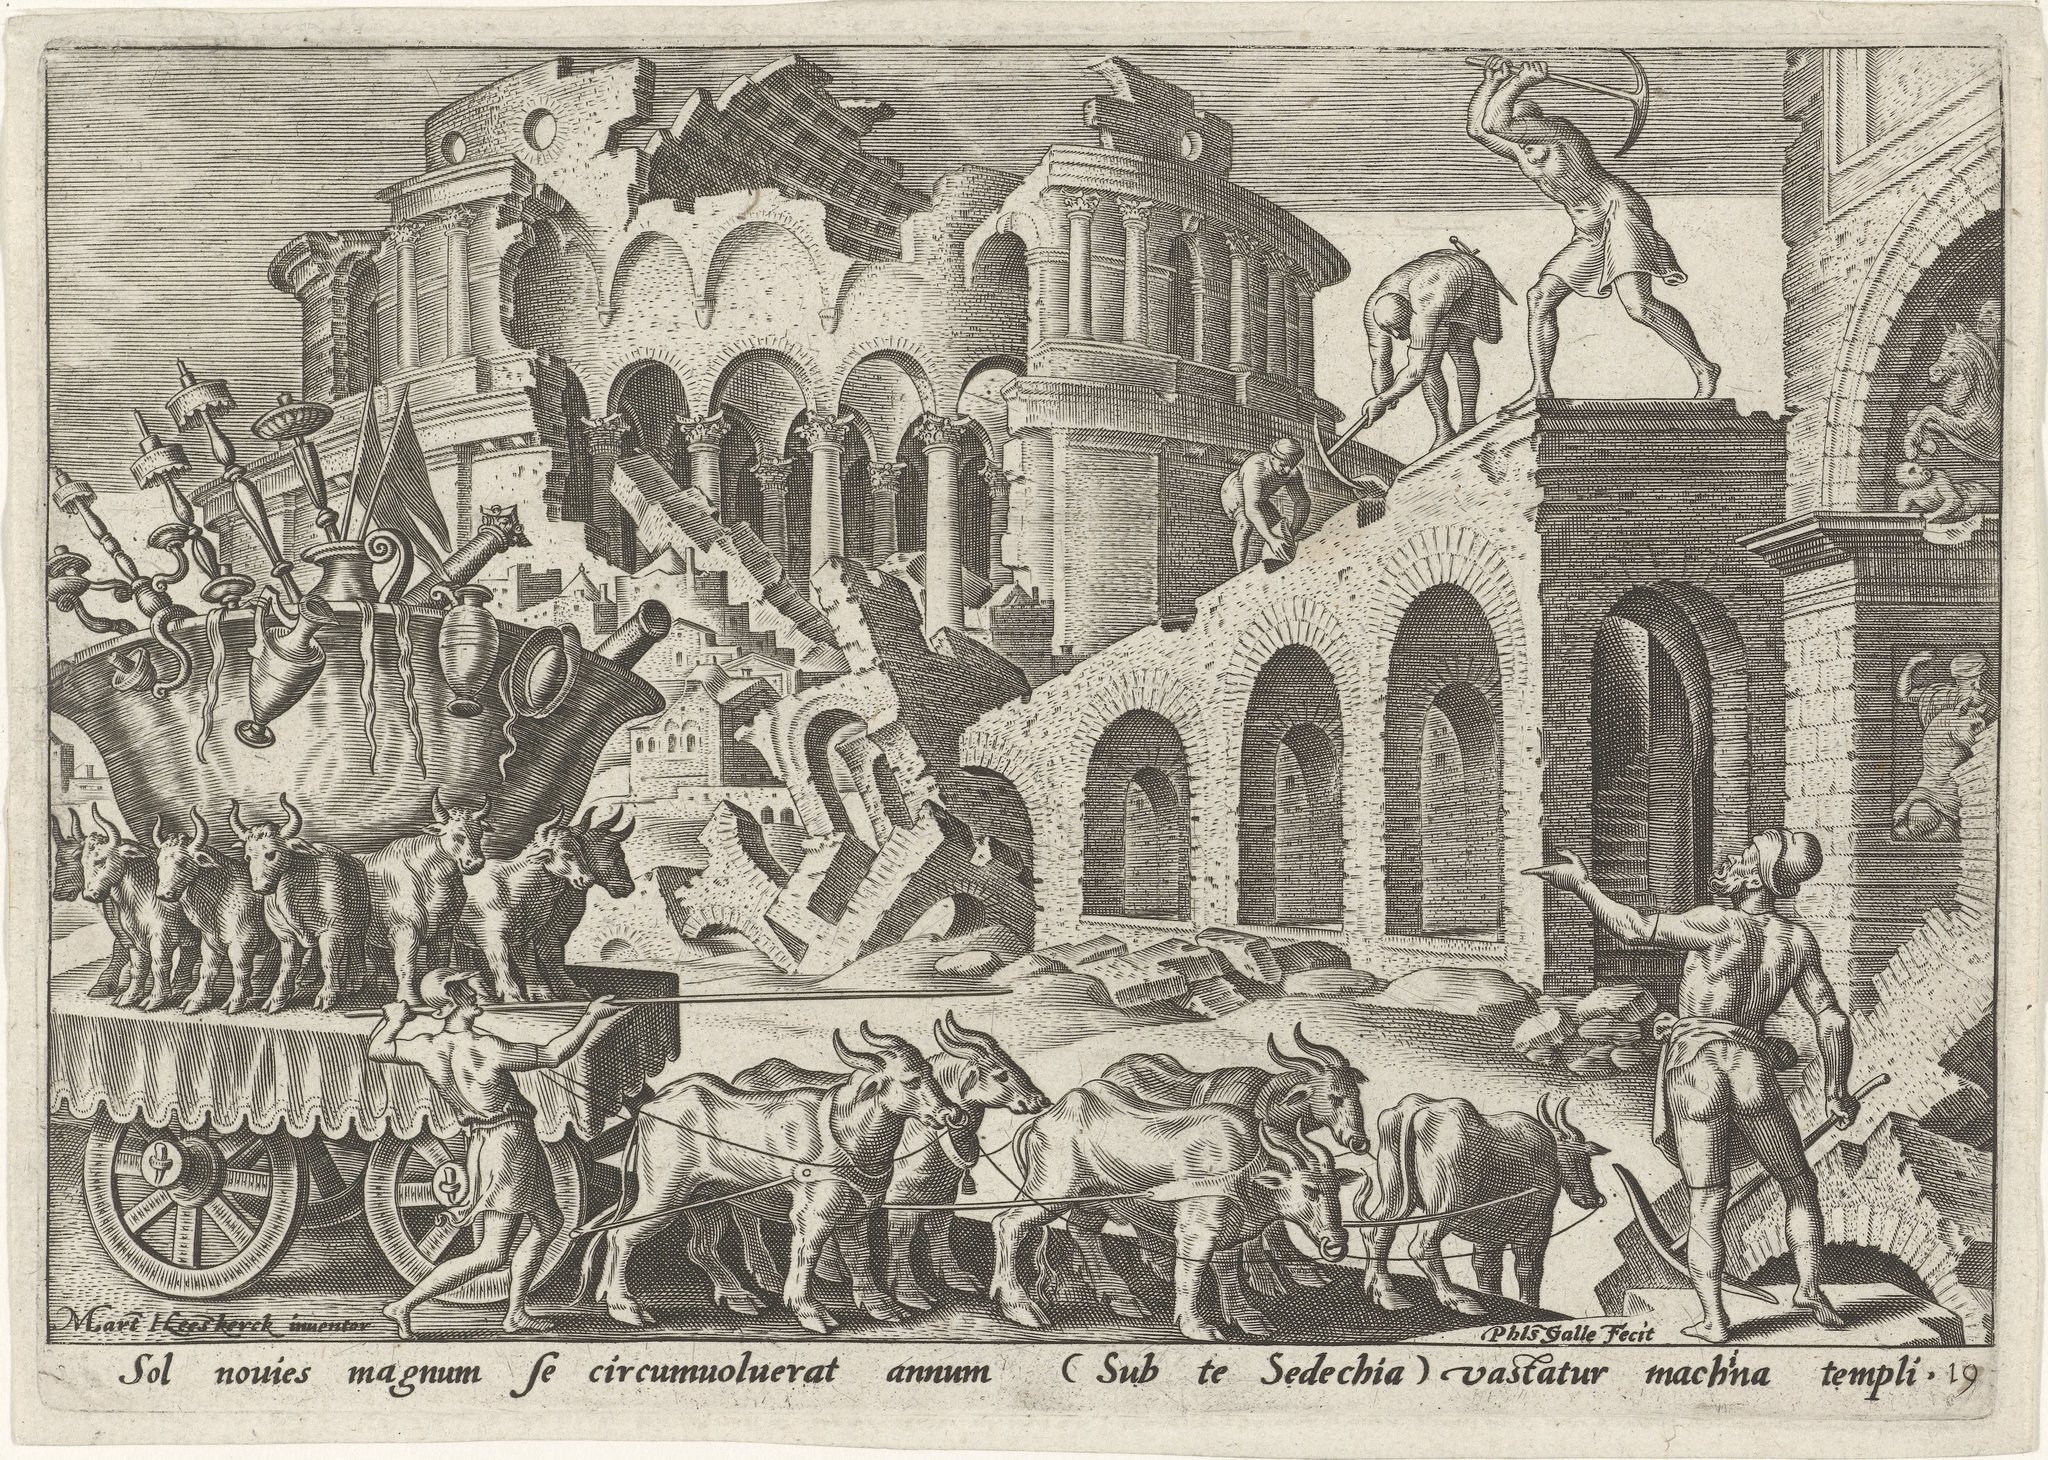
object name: print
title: De Chaldeeën plunderen de tempel van Jeruzalem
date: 1569-1650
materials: paper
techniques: engraving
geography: haarlem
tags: the temple of jerusalem is looted ~ story of zedekiah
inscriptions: caption: ‘Sol novies magnum se circumuoluerat abbum...machina templi.’, signature: ‘Mart Hee[m]s kerck inventor’, signature: ‘Phls Galle Fecit’, number: ‘19’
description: De tempel wordt door mannen met houwelen vernietigd. Op de voorgrond een ossenkar waarop de tempelschatten worden weggevoerd. Prent 19 uit een reeks van 21 prenten en een titelprent.